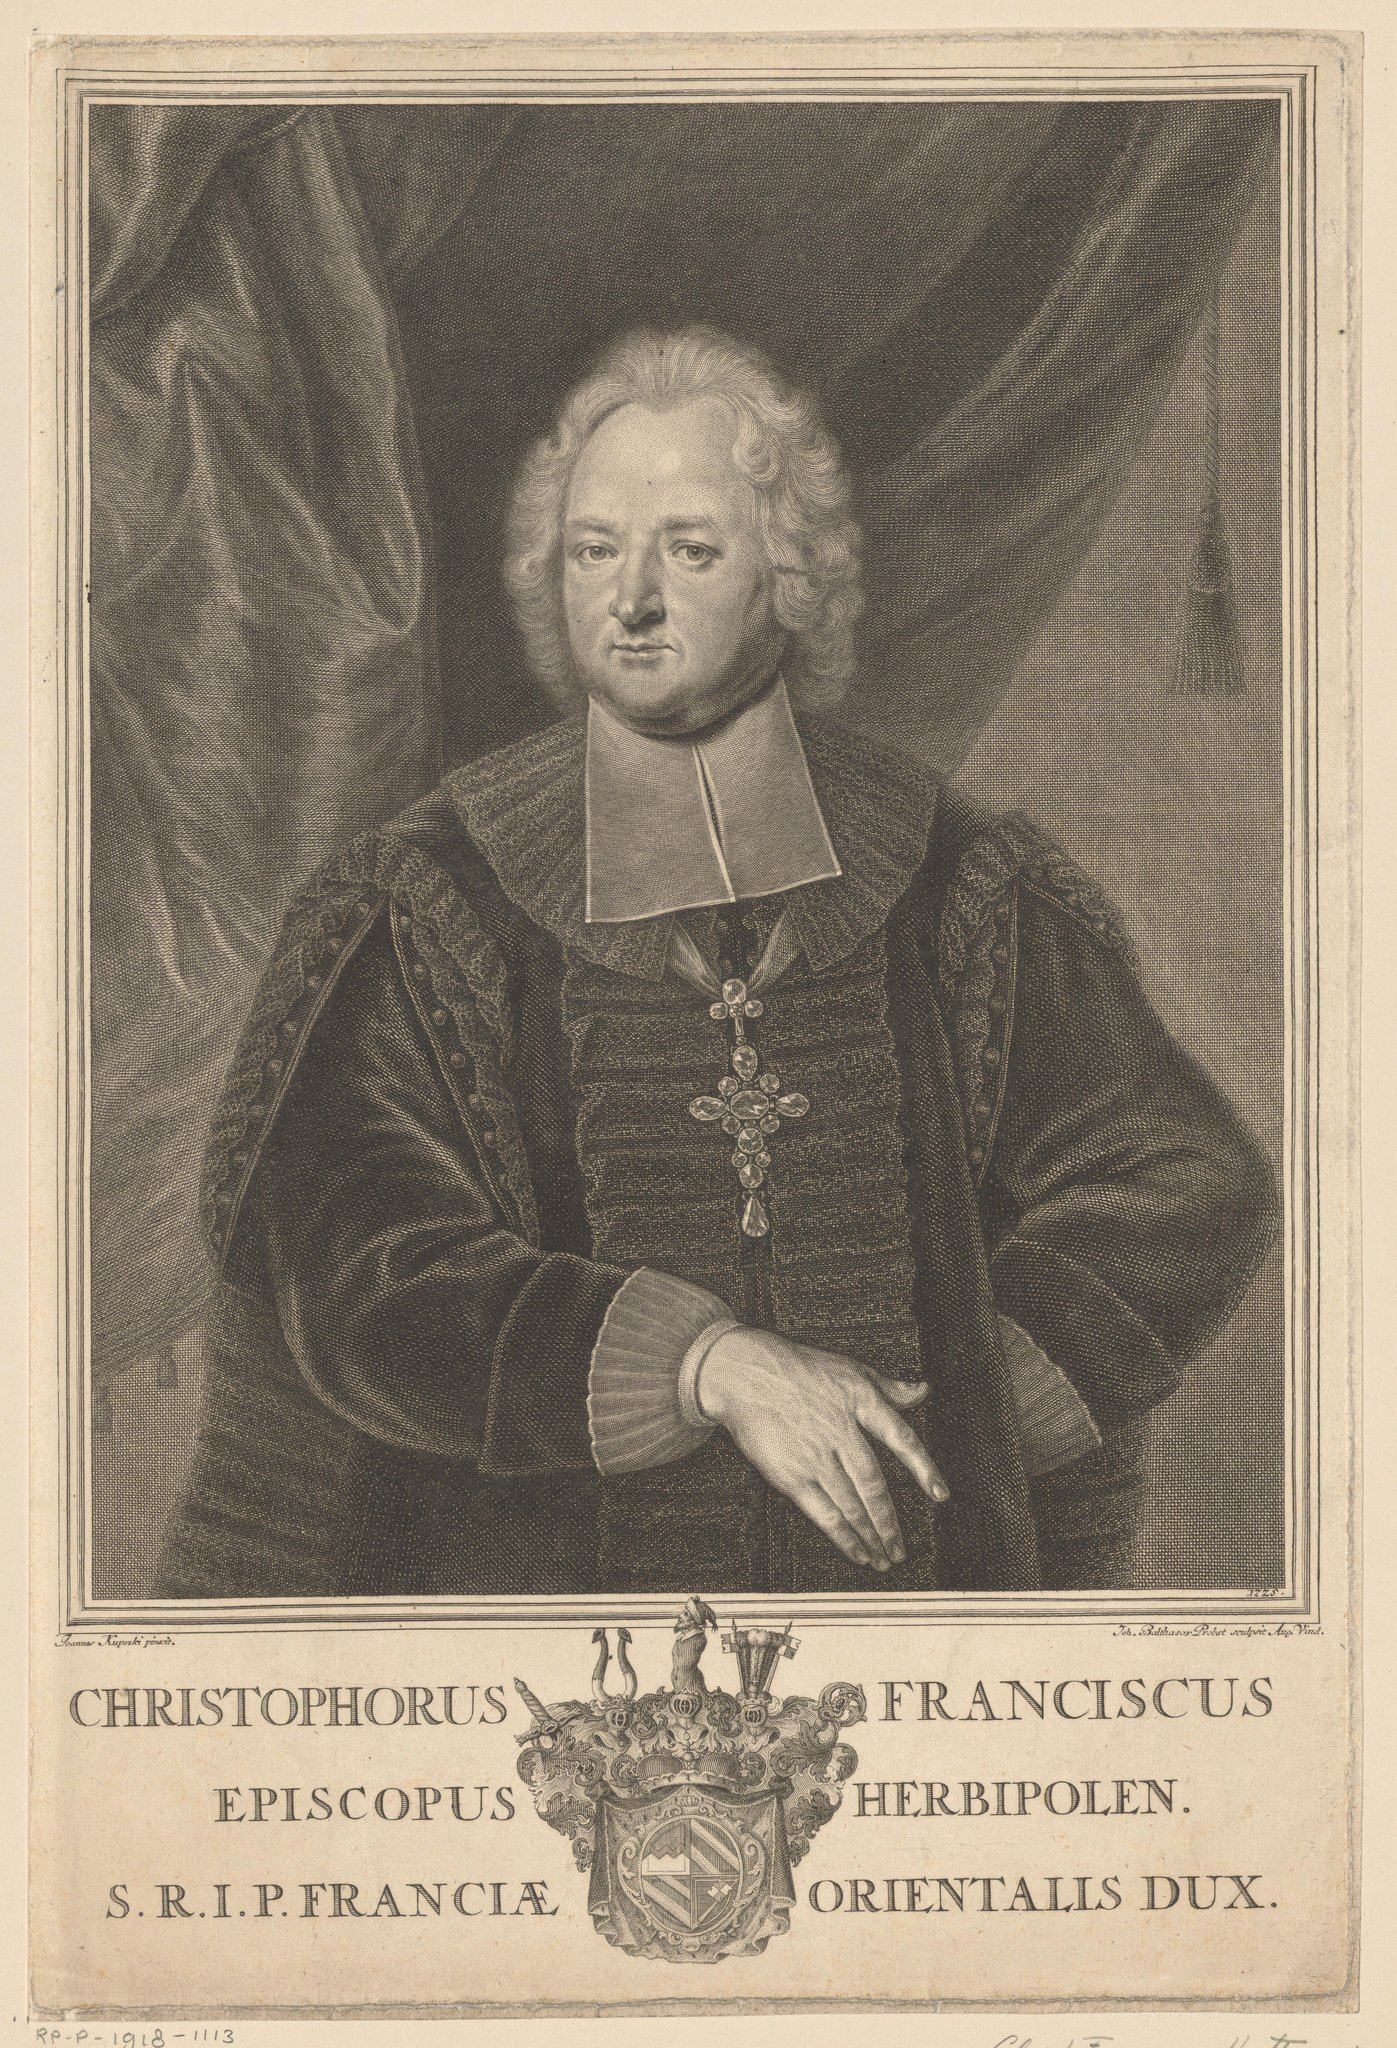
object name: print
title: Portret van Christoph Franz von Hutten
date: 1725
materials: paper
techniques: engraving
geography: augsburg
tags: archbishop, bishop, etc. (roman catholic), historical persons, armorial bearing, heraldry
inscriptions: collector's mark: Lugt 2233